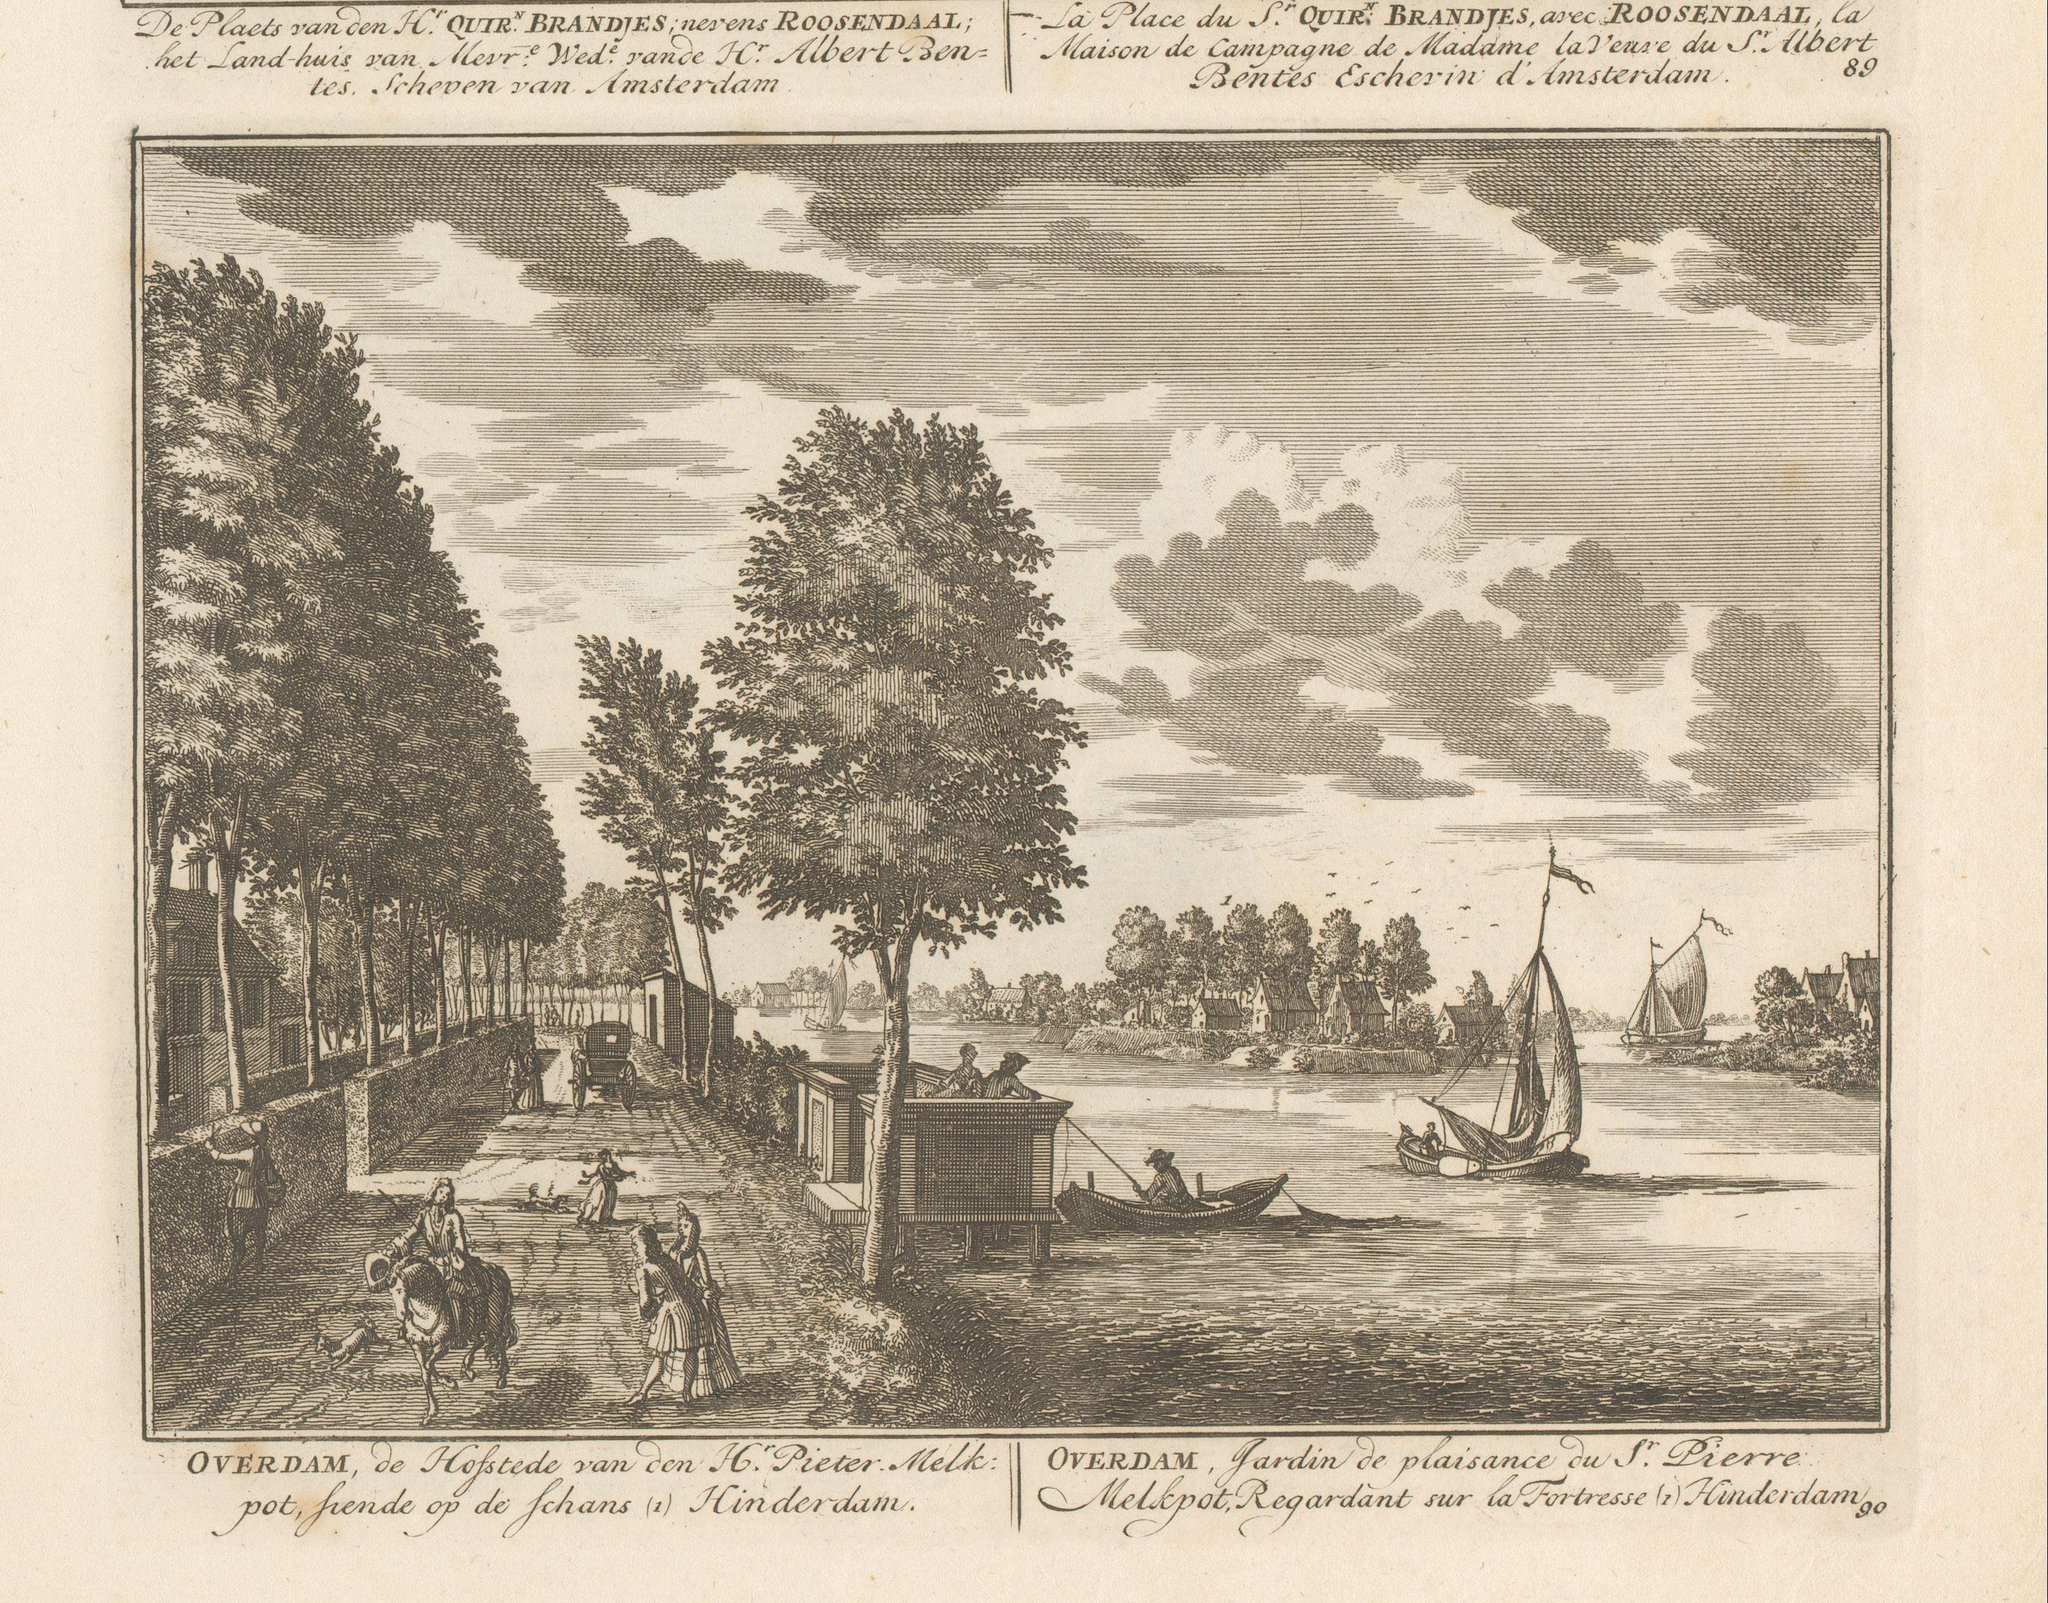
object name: print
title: Overdam, de Hofstede van den H. Pieter Melkpot, siende op de schans (1) Hinterdam / Overdam, Jardin de plaisance du S. Pierre Melkpot, Regardant sur la Fortresse (1) Hinterdam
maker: daniël stopendaal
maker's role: print maker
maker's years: 1672-1726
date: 1790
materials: paper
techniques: engraving, etching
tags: river (+ landscape with figures, staffage), country-house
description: Prent gebruikt in: Leth, Andries de. De zegepraalende Vecht, vertoonende verscheidene gesichten van lustplaatsen, heeren huysen en dorpen, beginnende van Uitrecht en met Muyden besluytende (...). Amsterdam: Weduwe Nicolaus Visscher, 1719. Prent ook gebruikt in: Brouërius van Nidek, Matthaeus. De Vechtstroom, van Utrecht tot Muiden (...). Amsterdam: H. Gartman, W. Vermandel en J.W. Smit, 1790.